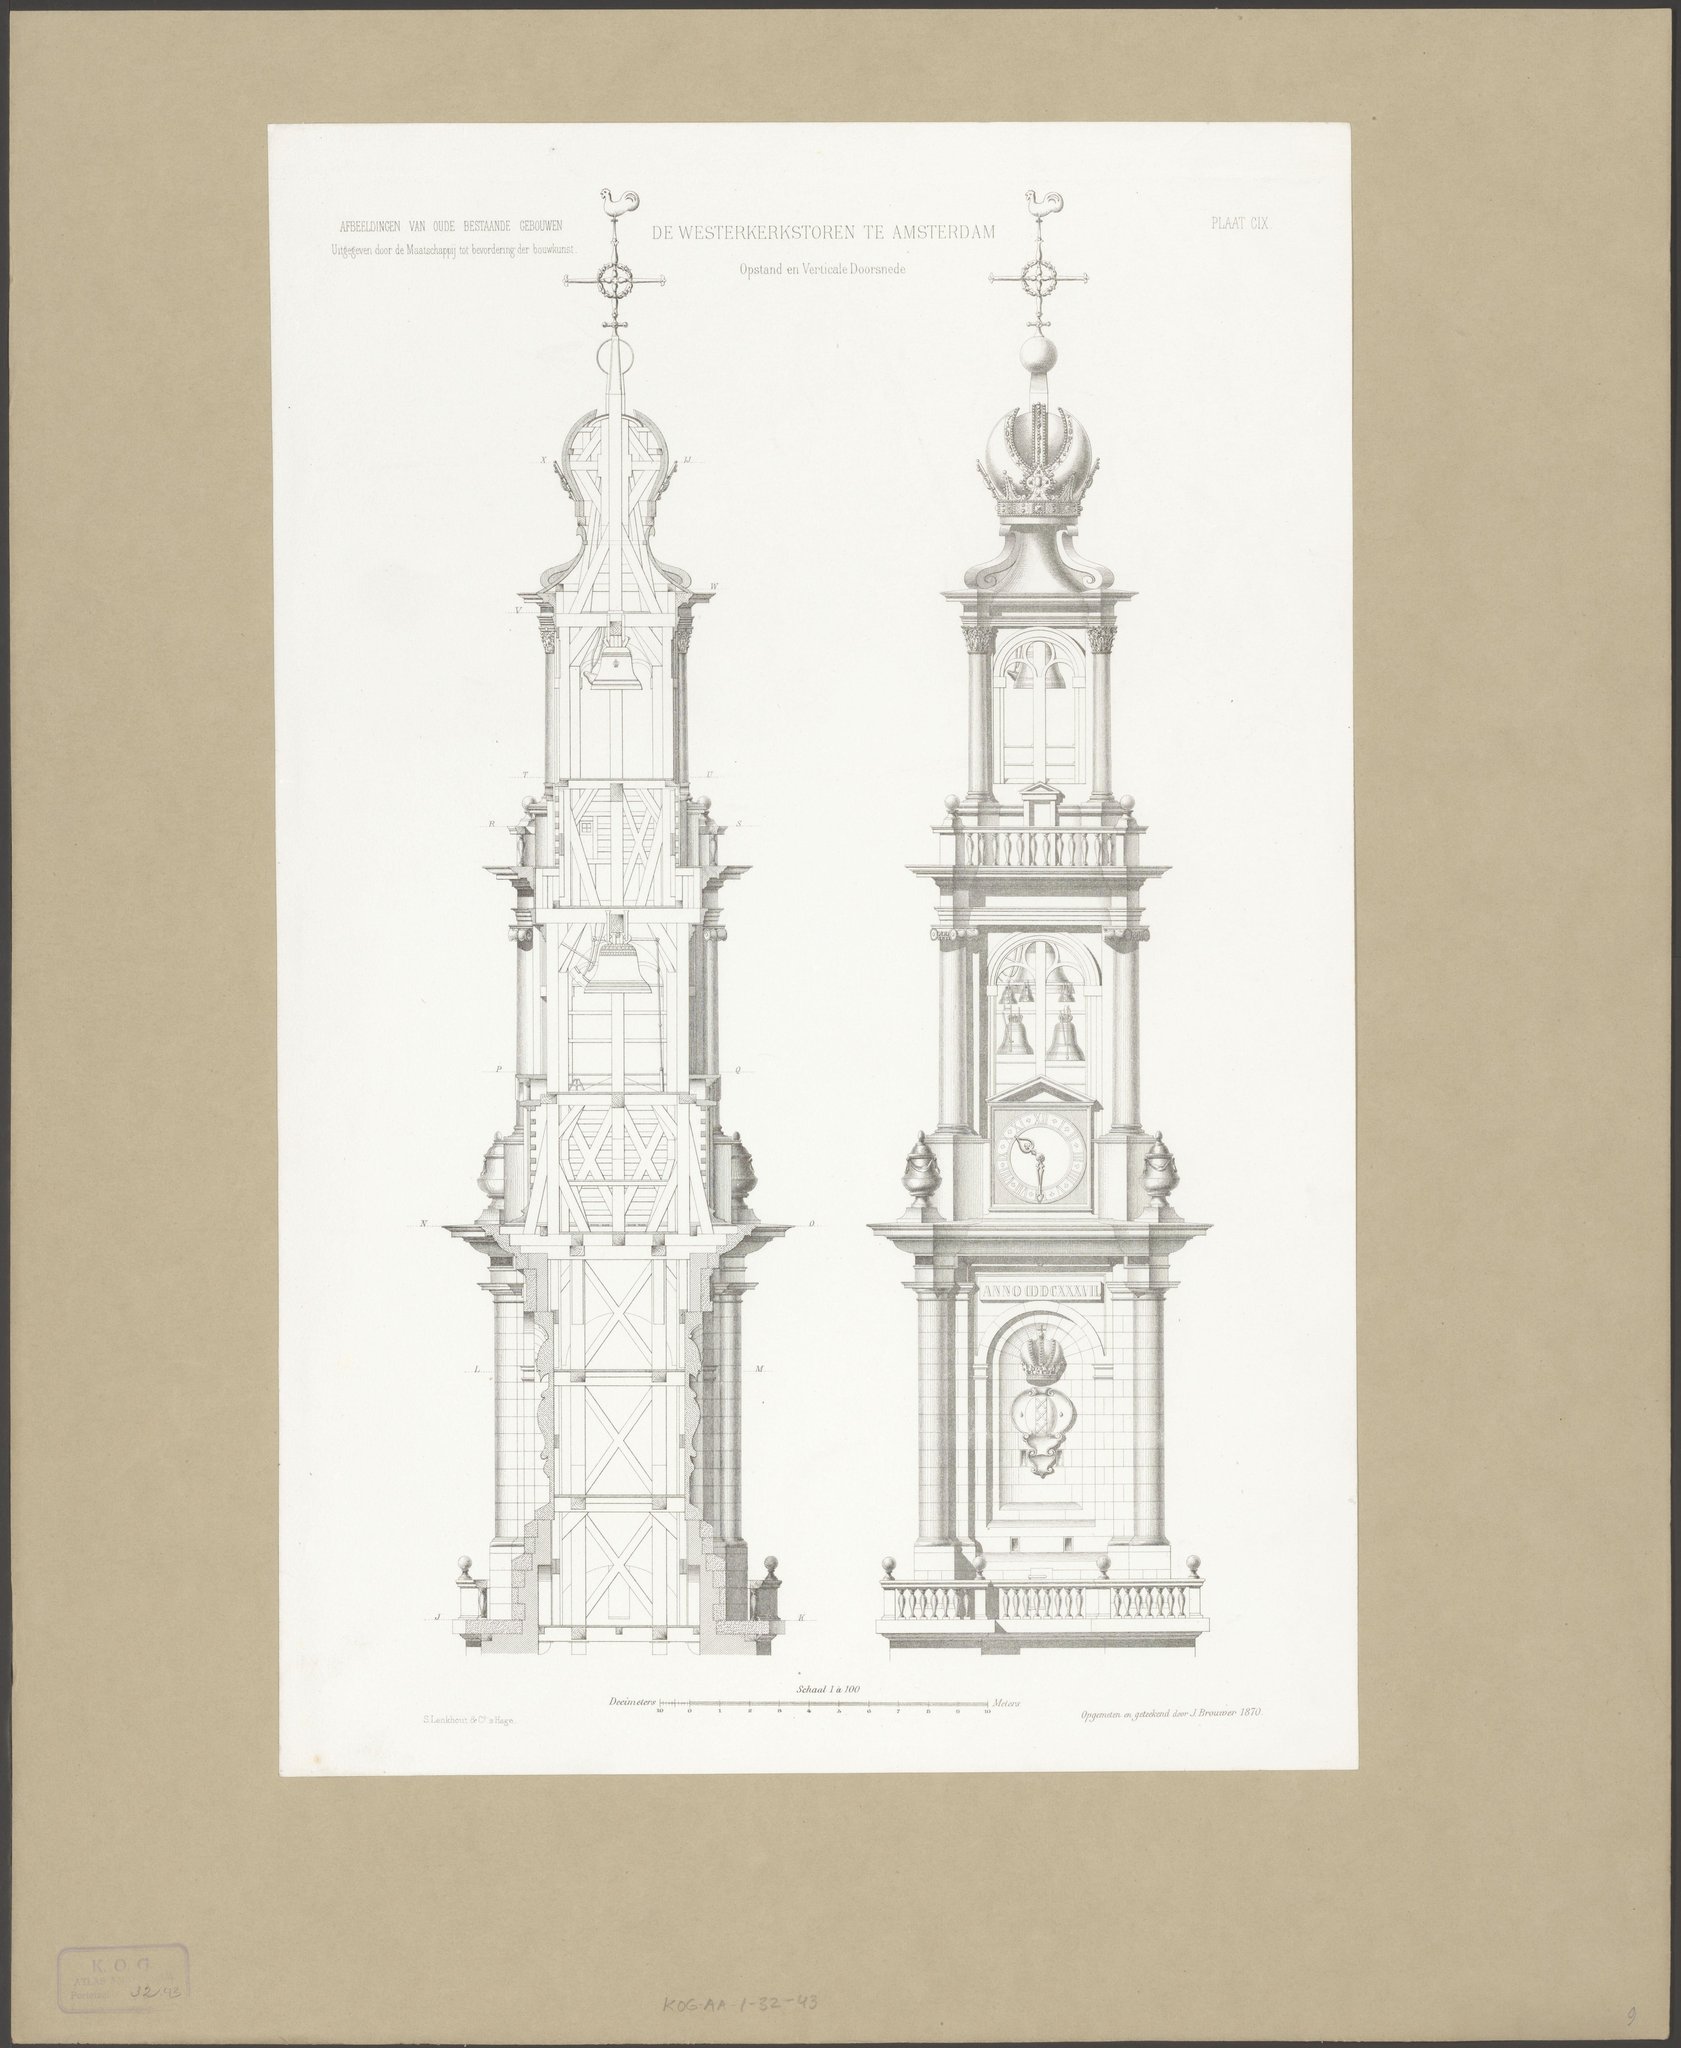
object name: photomechanical print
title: Opstand en doorsnede van de Westertoren te Amsterdam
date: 1870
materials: paper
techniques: photolithography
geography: the hague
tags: plan ~ architecture, parts of church exterior and annexes: tower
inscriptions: collector's mark: ‘32.43’ Lugt 1641b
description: Rechtsboven genummerd: CIX. Onderaan een schaalroede. Onderwerpsrubriek binnen de Atlas Amsterdam: Kerkwezen: Hervormde Gemeente: Westerkerk.